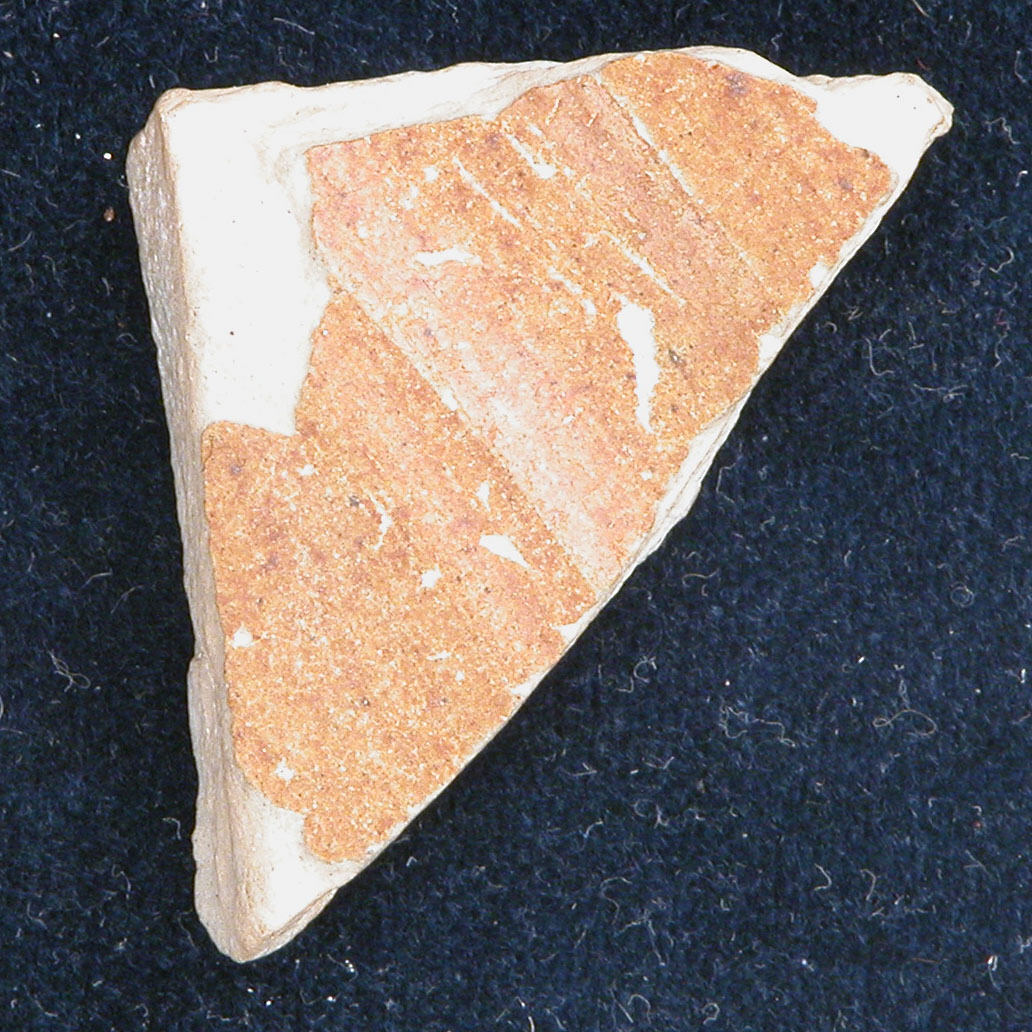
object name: fragment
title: Ceramic Fragment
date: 701-1000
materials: stonepaste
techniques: glazing, painting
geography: saudi arabia